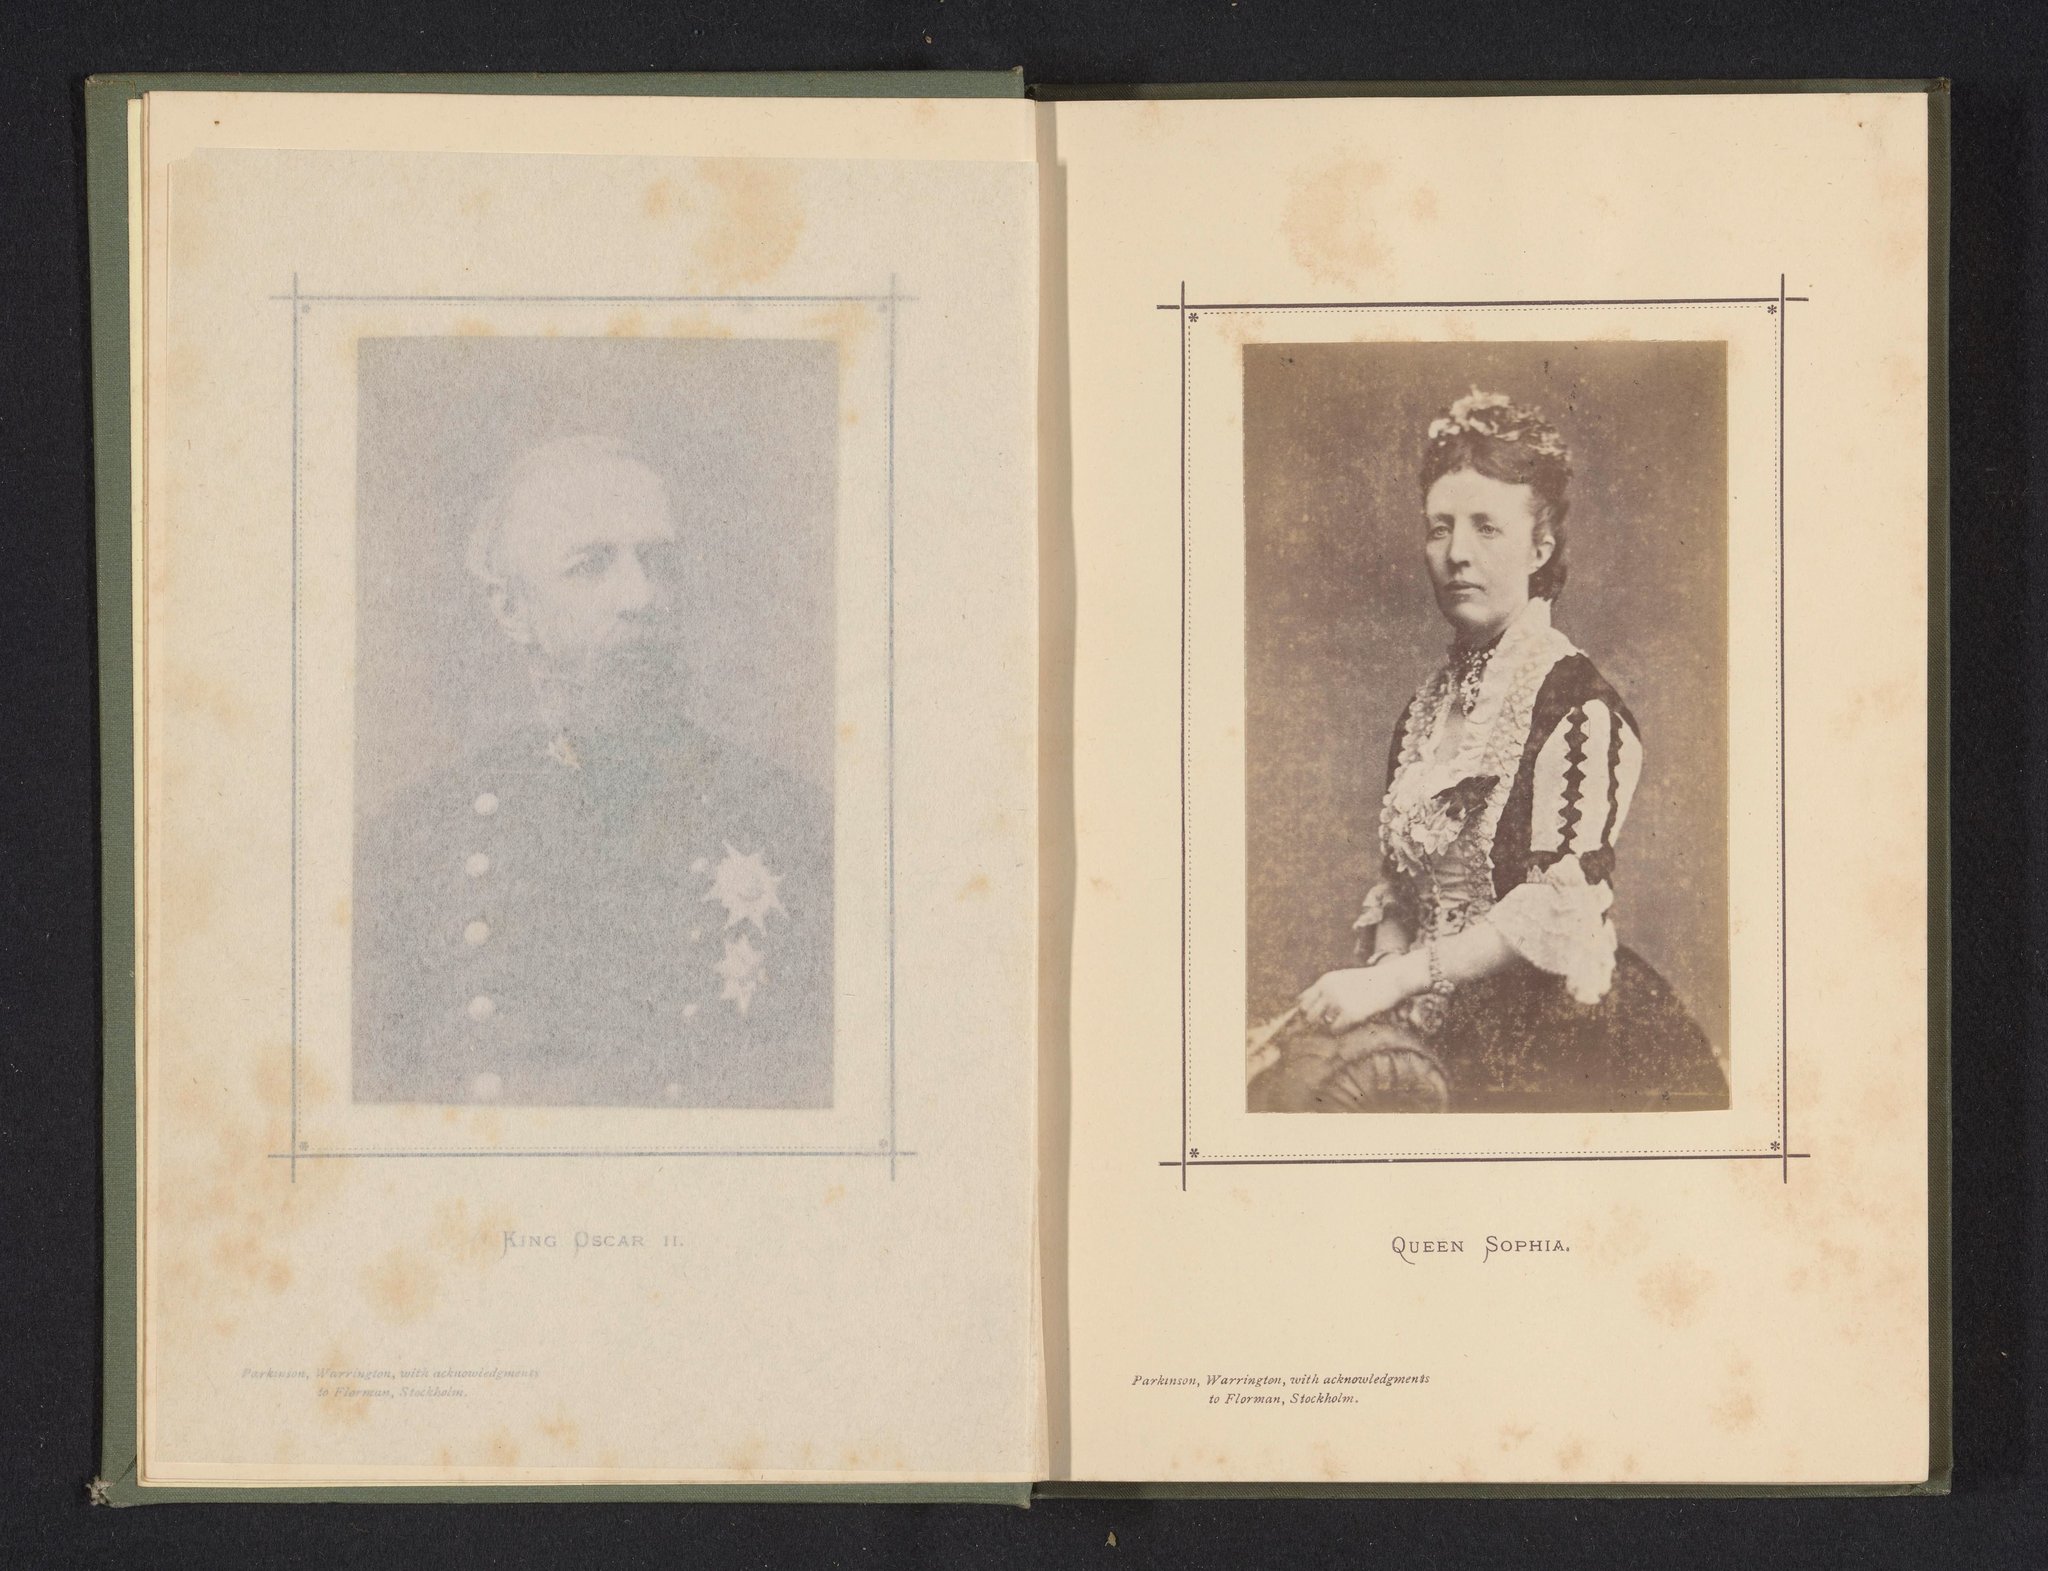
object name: photograph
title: Queen Sophia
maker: gösta florman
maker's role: fotograaf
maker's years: 1831-1900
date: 1882-1887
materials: photographic support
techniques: albumen print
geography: stockholm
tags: ruler, sovereign - bb - female ruler